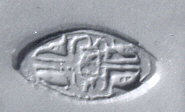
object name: stamp seal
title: Cowroid seal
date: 1700-1520 BCE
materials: stone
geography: egypt or levant